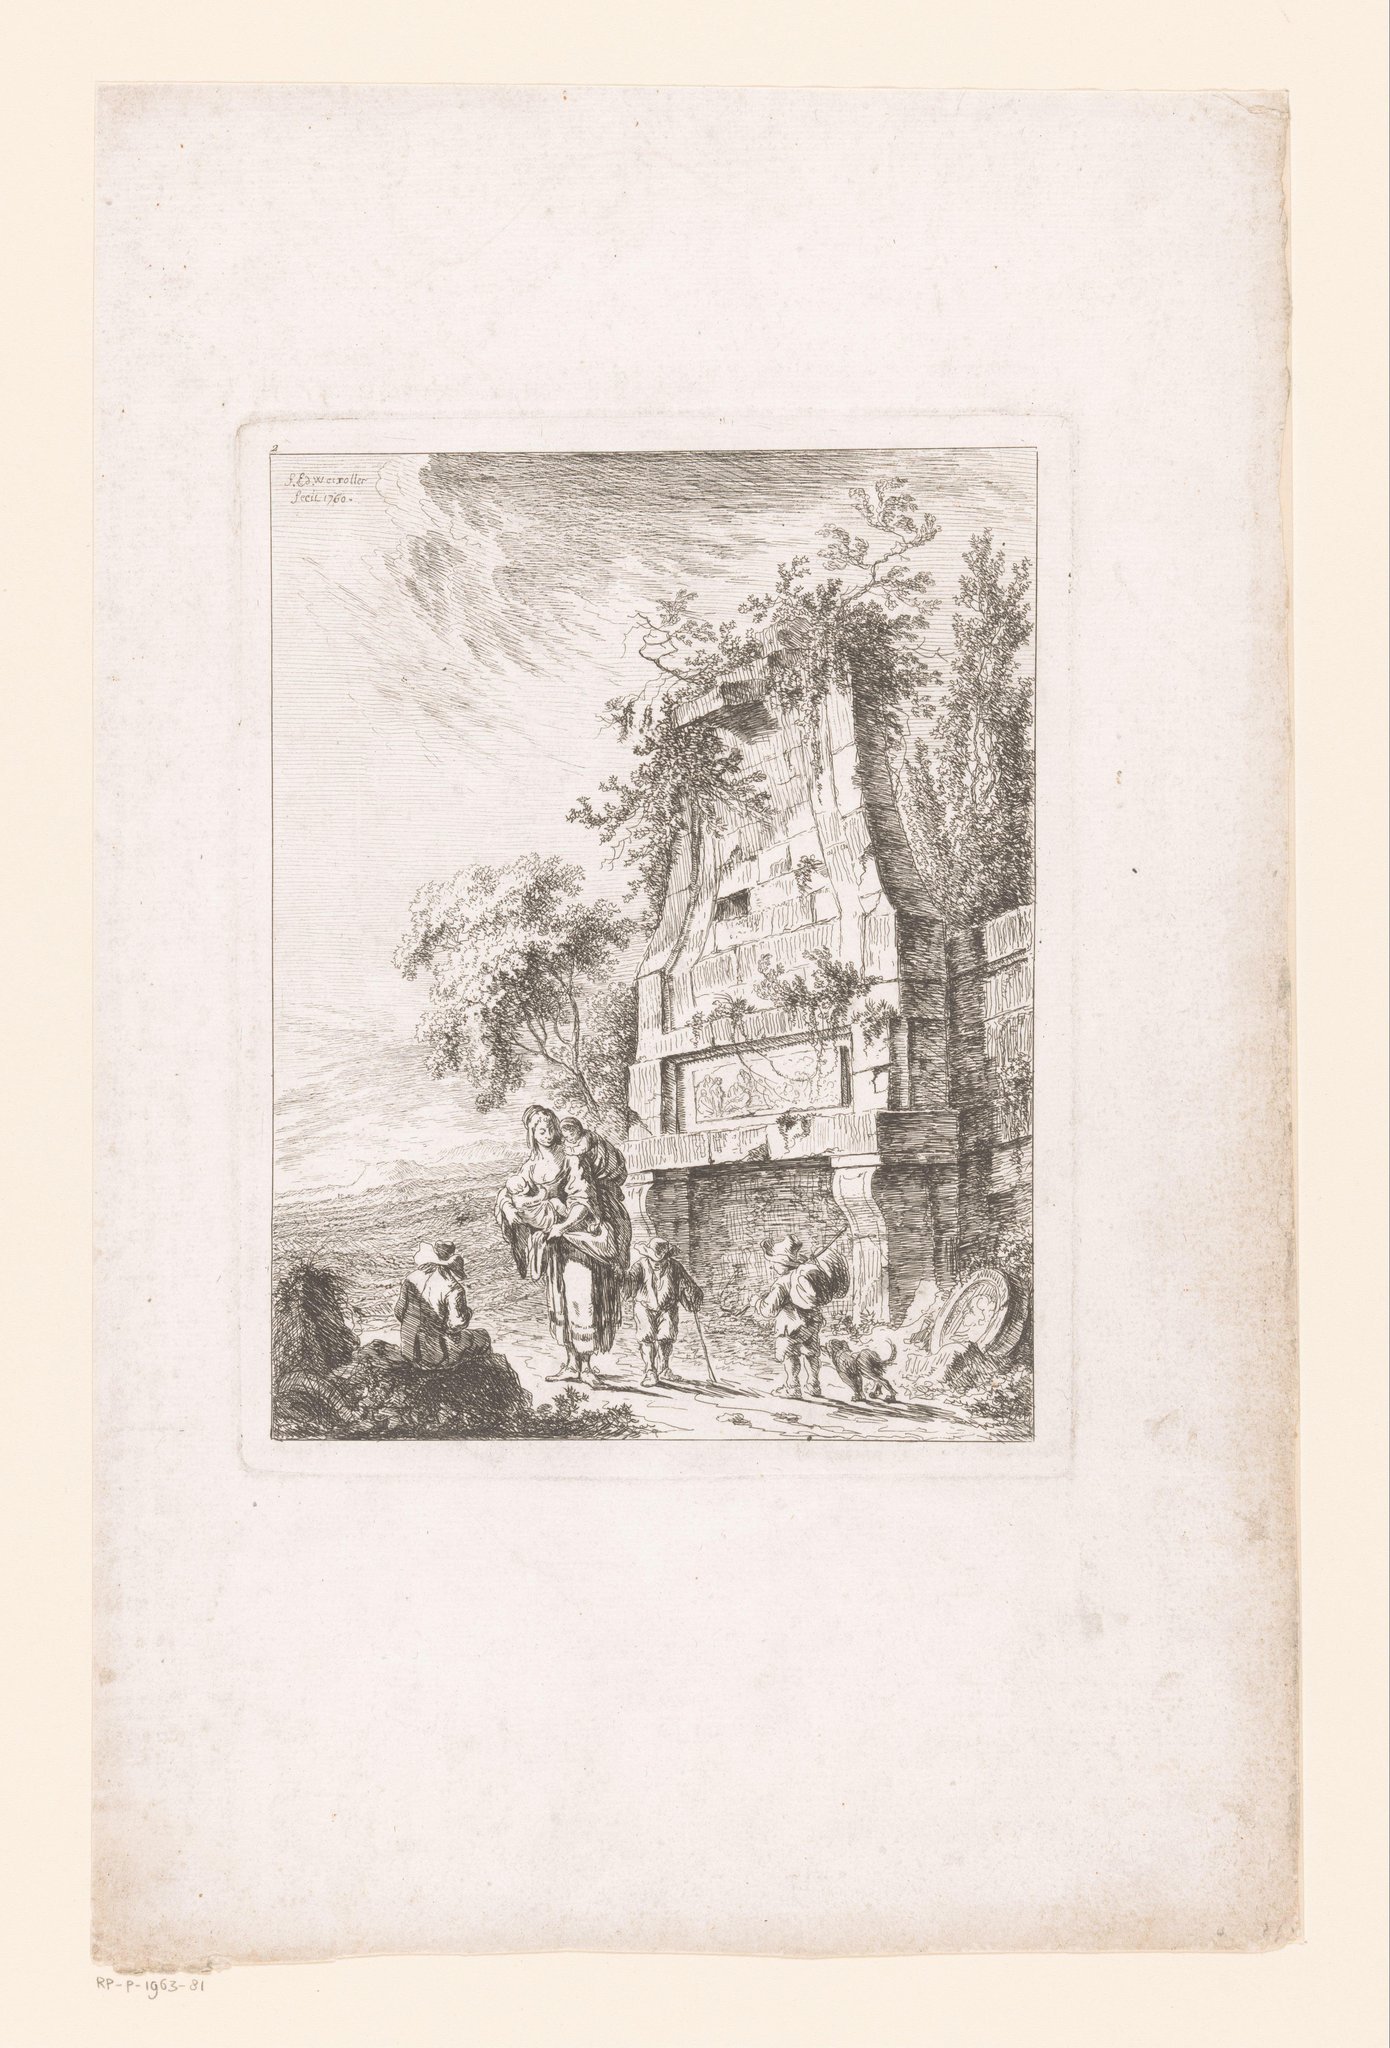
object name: print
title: Vrouw met kinderen bij een ruïne van een monument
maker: franz edmund weirotter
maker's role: draughtsman, painter, print maker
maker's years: 1733-1771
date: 1760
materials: paper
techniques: etching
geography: paris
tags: landscape with ruins, landscape with monument, 'en route', traveller under way, mother and child(ren), woman and child(ren) (family group)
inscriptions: collector's mark: Lugt 2760, collector's mark: Lugt 2228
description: Prent maakt deel uit van een serie van zes prenten met landschappen en ruïnes. In de collectie Rijksmuseum bevinden zich vier van de zes prenten (nummers 1, 2, 3 en 6).